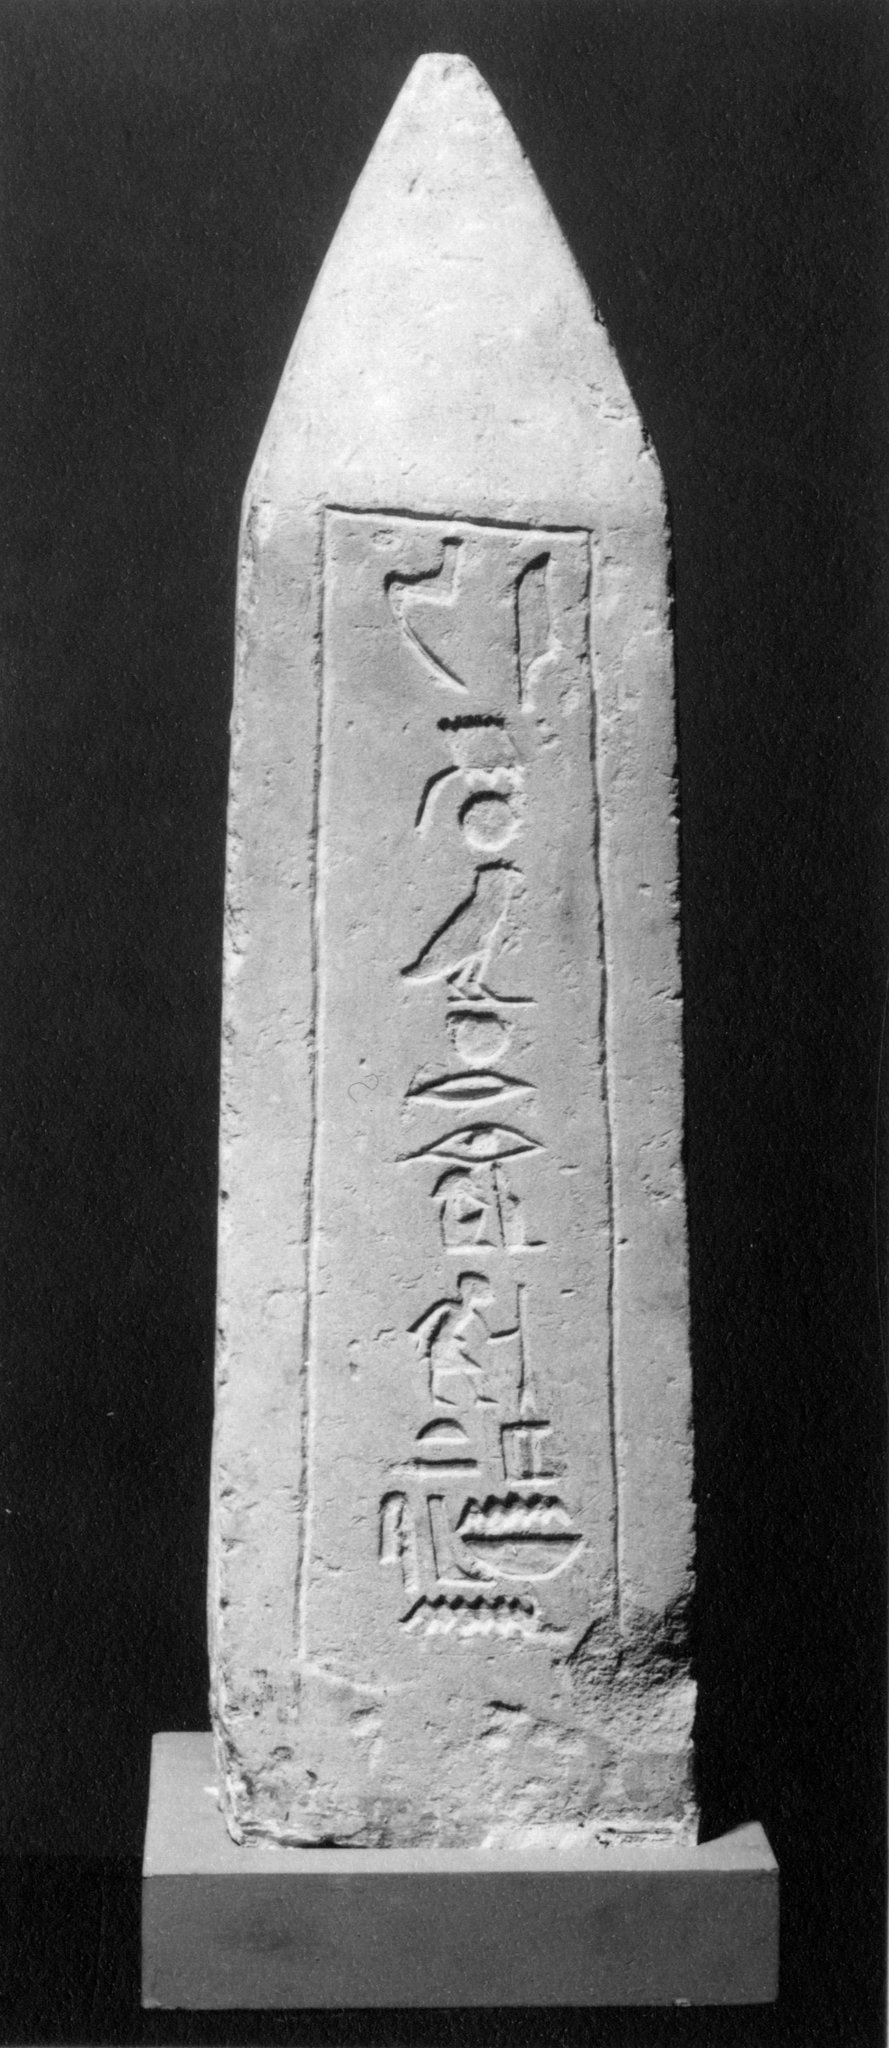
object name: obelisk, nebsen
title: Obelisk of Nebsen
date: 2323-2100 BCE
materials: limestone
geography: egypt